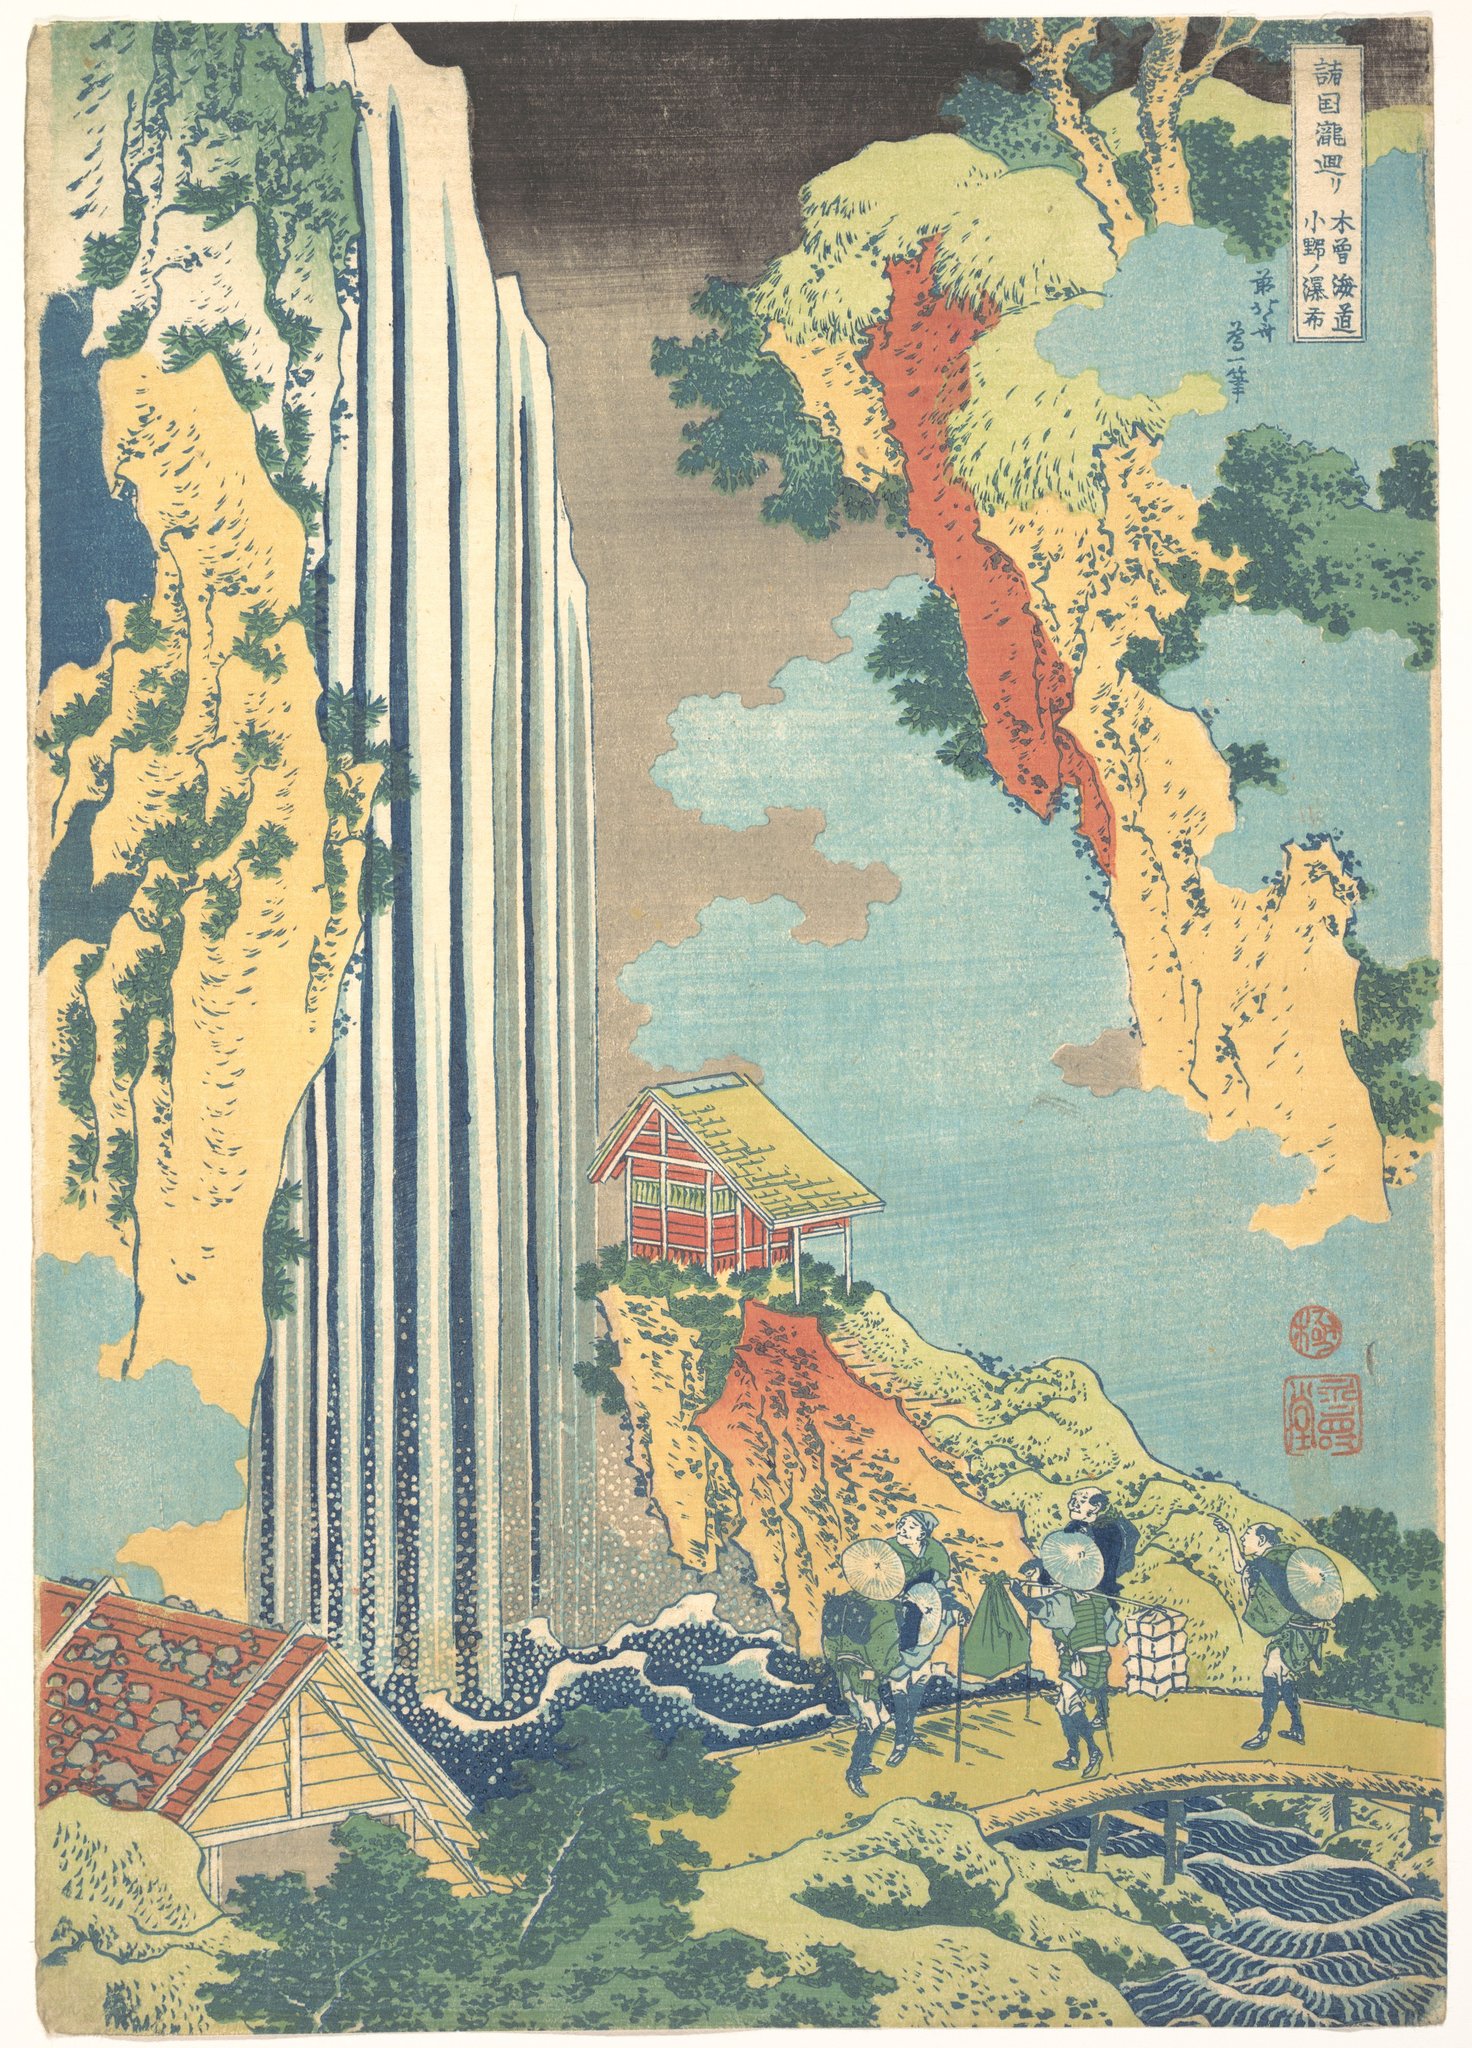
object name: woodblock print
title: Ono Waterfall on the Kisokaidō (Kisokaidō Ono no bakufu), from the series A Tour of Waterfalls in Various Provinces (Shokoku taki meguri)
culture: japanese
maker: katsushika hokusai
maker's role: artist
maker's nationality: japanese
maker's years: 1760-1849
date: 1833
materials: ink, paper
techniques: woodblock print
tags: bridges,waterfalls,streams